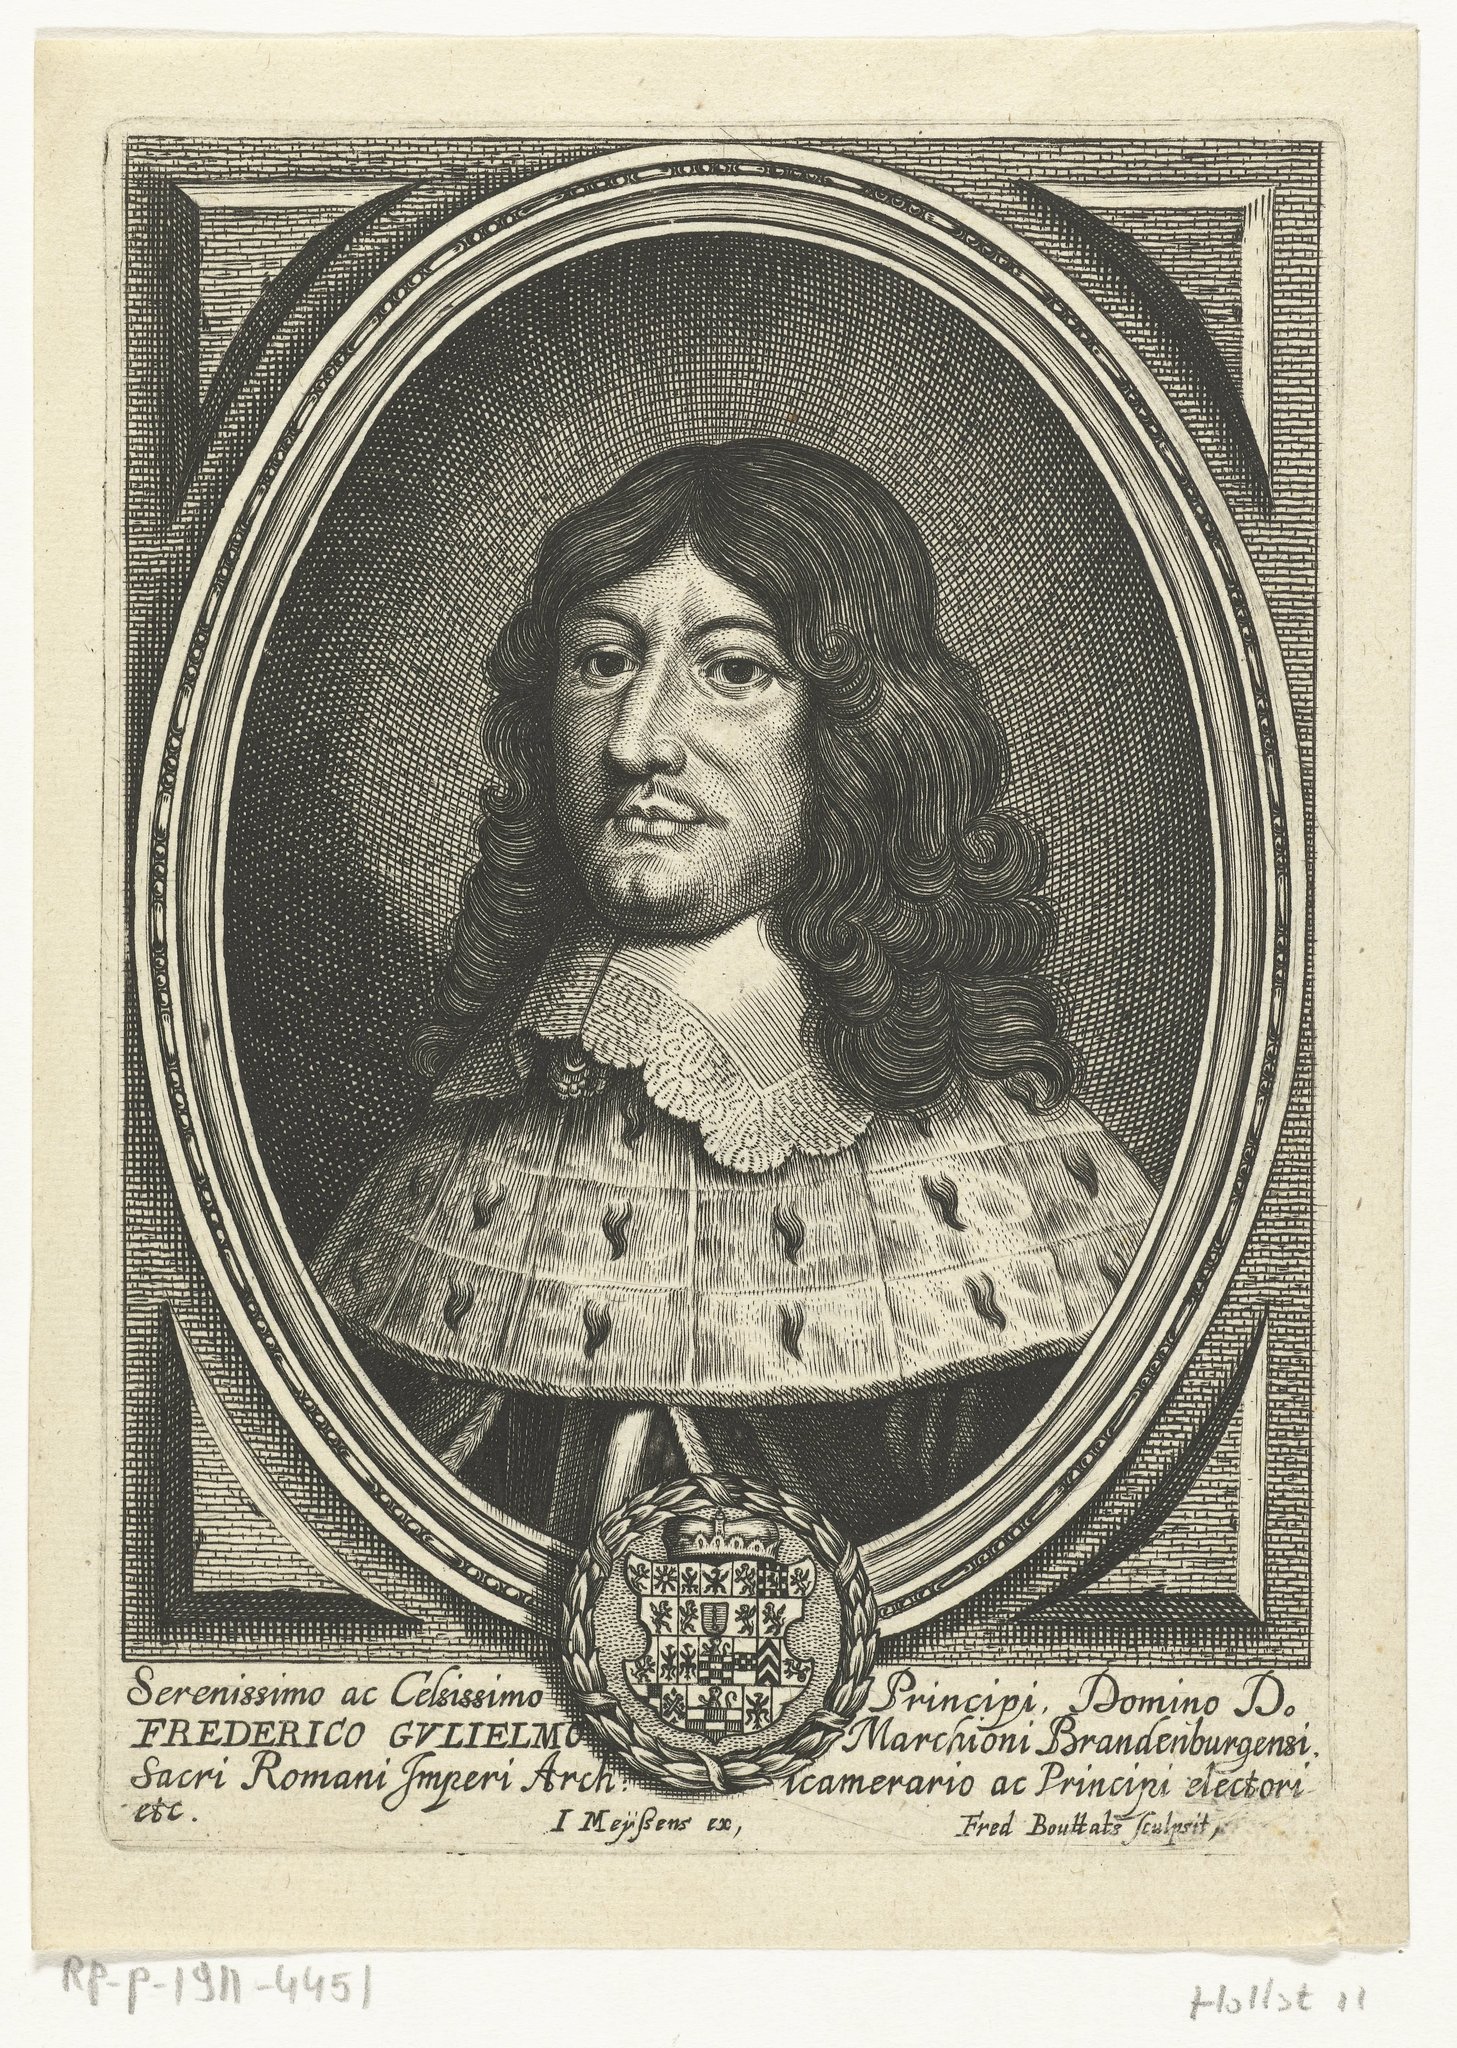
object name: print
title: Portret van Frederik Willem van Brandenburg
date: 1640-1676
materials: paper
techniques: engraving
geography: antwerp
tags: frederik willem van brandenburg (i)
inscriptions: collector's mark: Lugt 2228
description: Portret in een ovale lijst van keurvorst Frederik Willem van Brandenburg, ook wel de 'Grote Keurvorst' genoemd, . Buste naar links. Frederik Willem draagt een hermelijnen mantel. De prent heeft een Italiaans onderschrift met de naam van de geportretteerde.